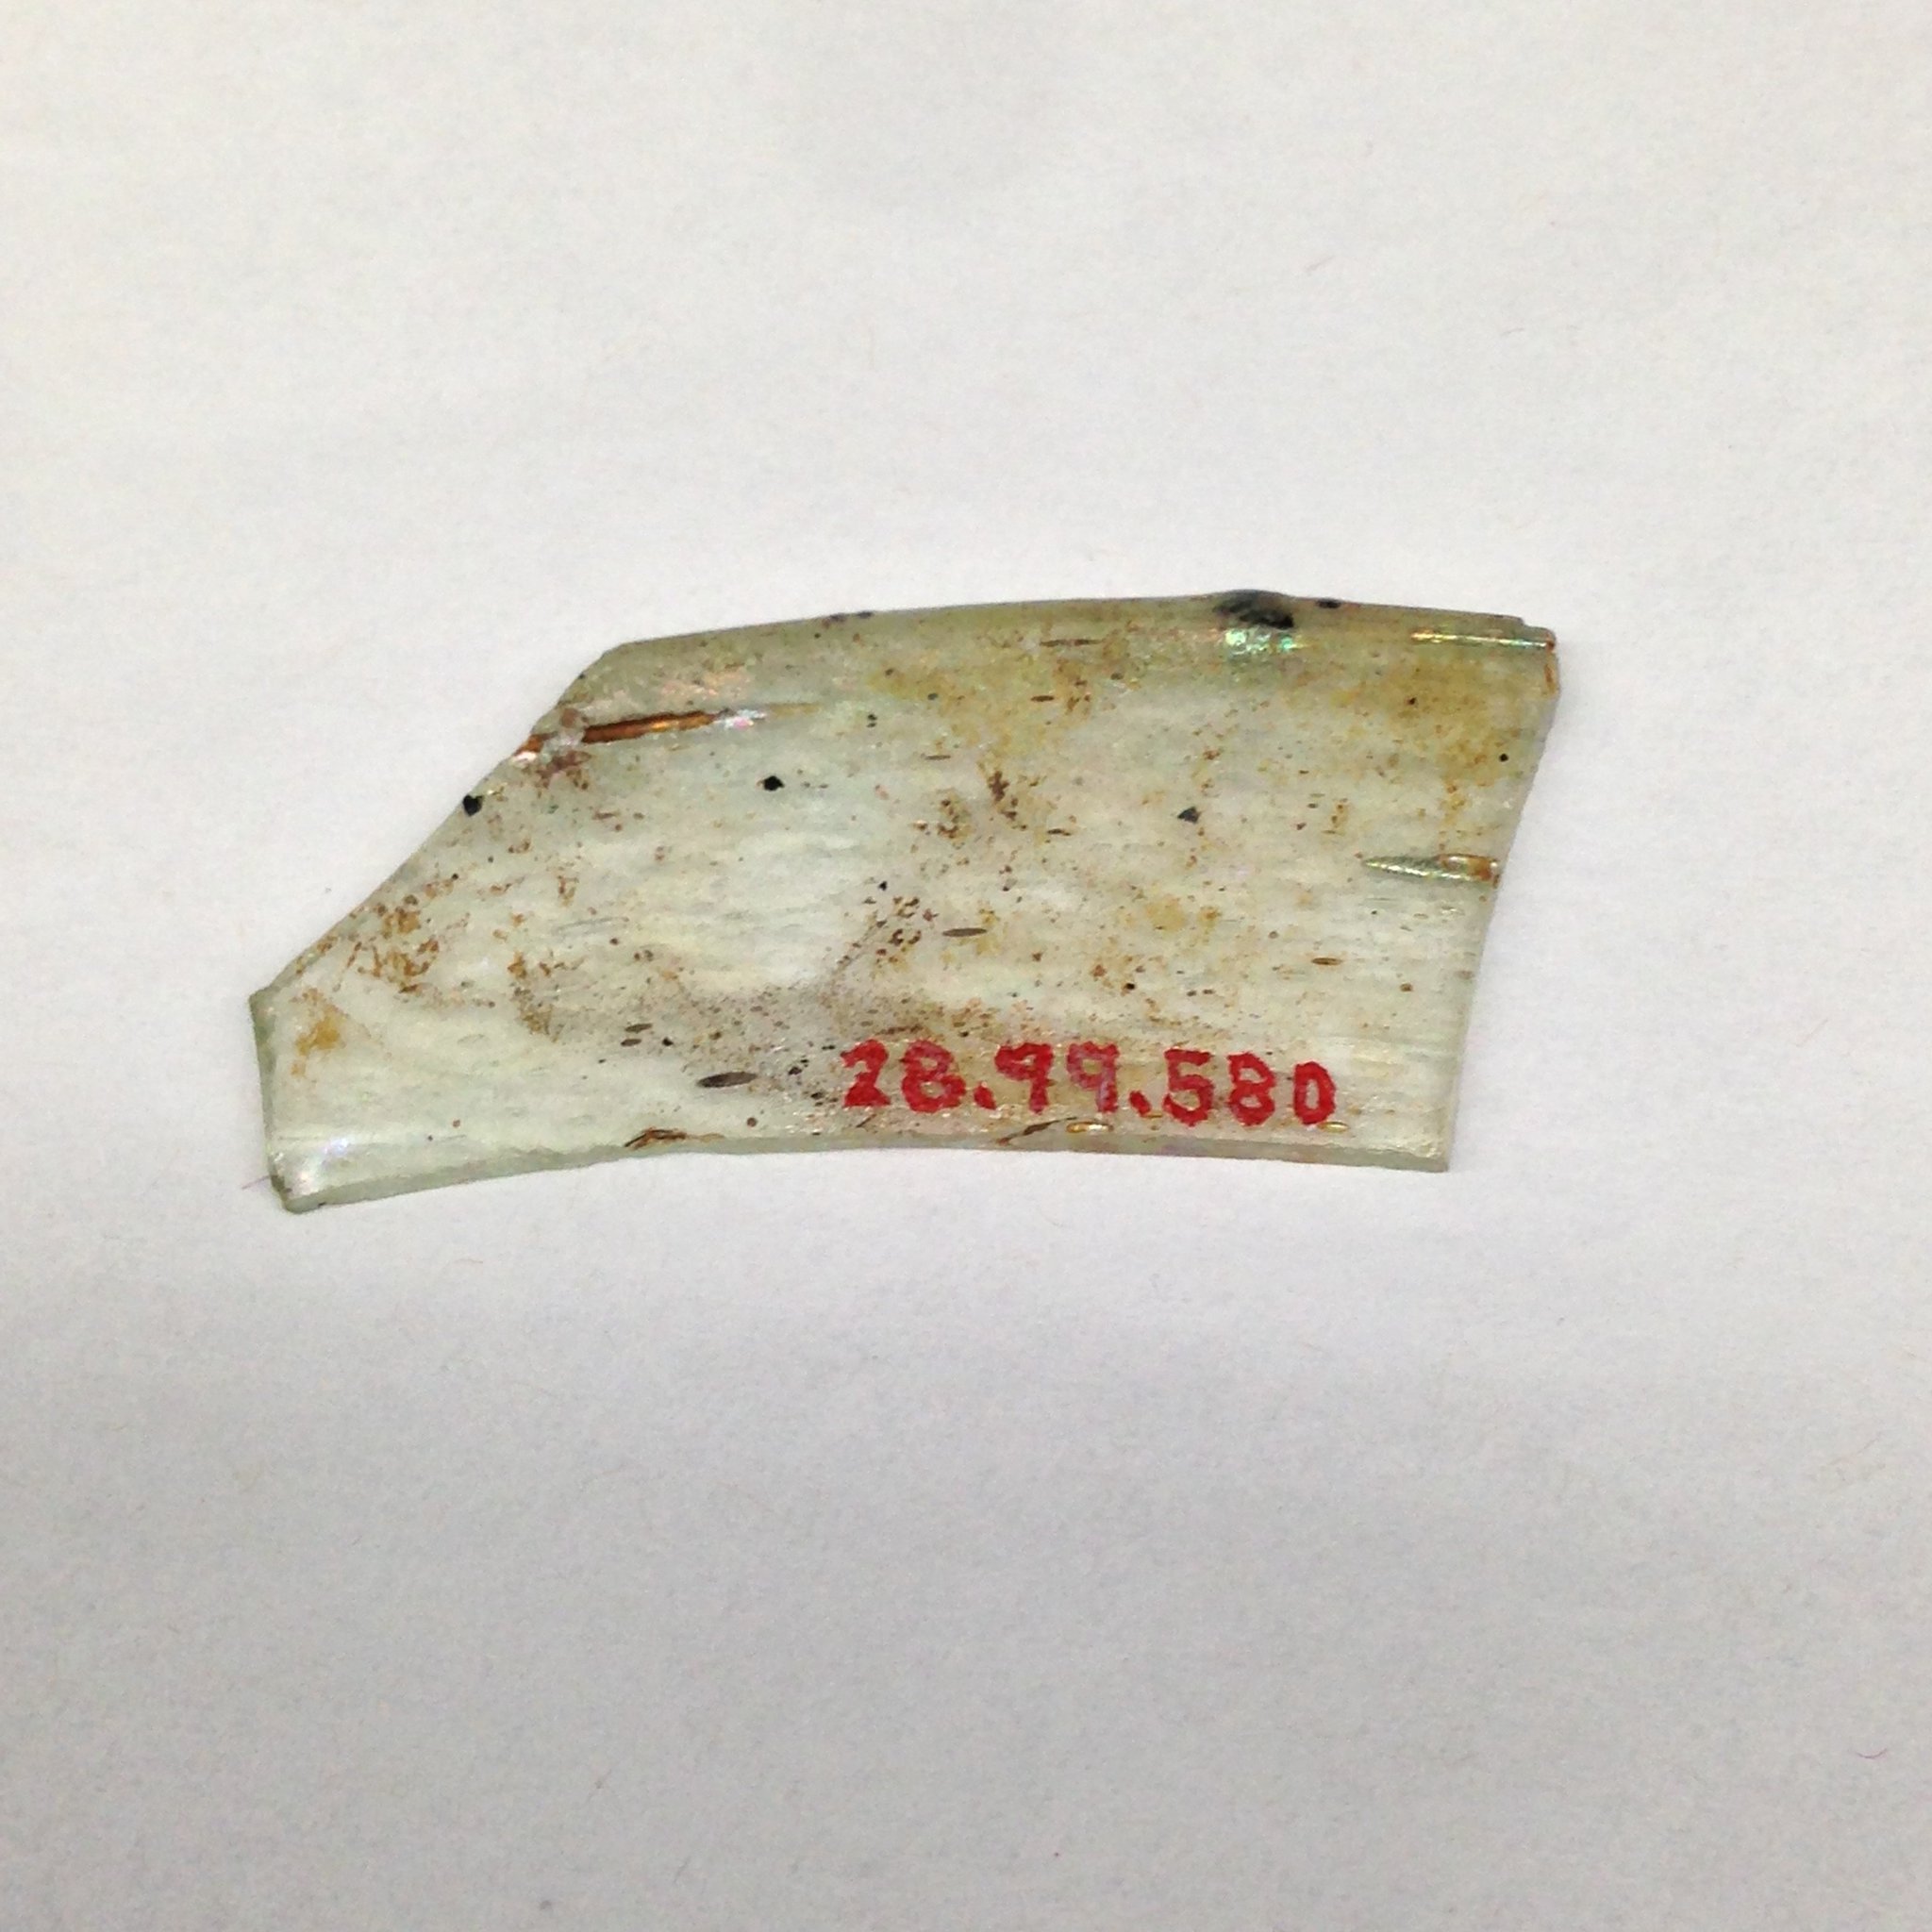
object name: fragment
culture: european or middle eastern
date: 1150-1250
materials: ceramic, glass